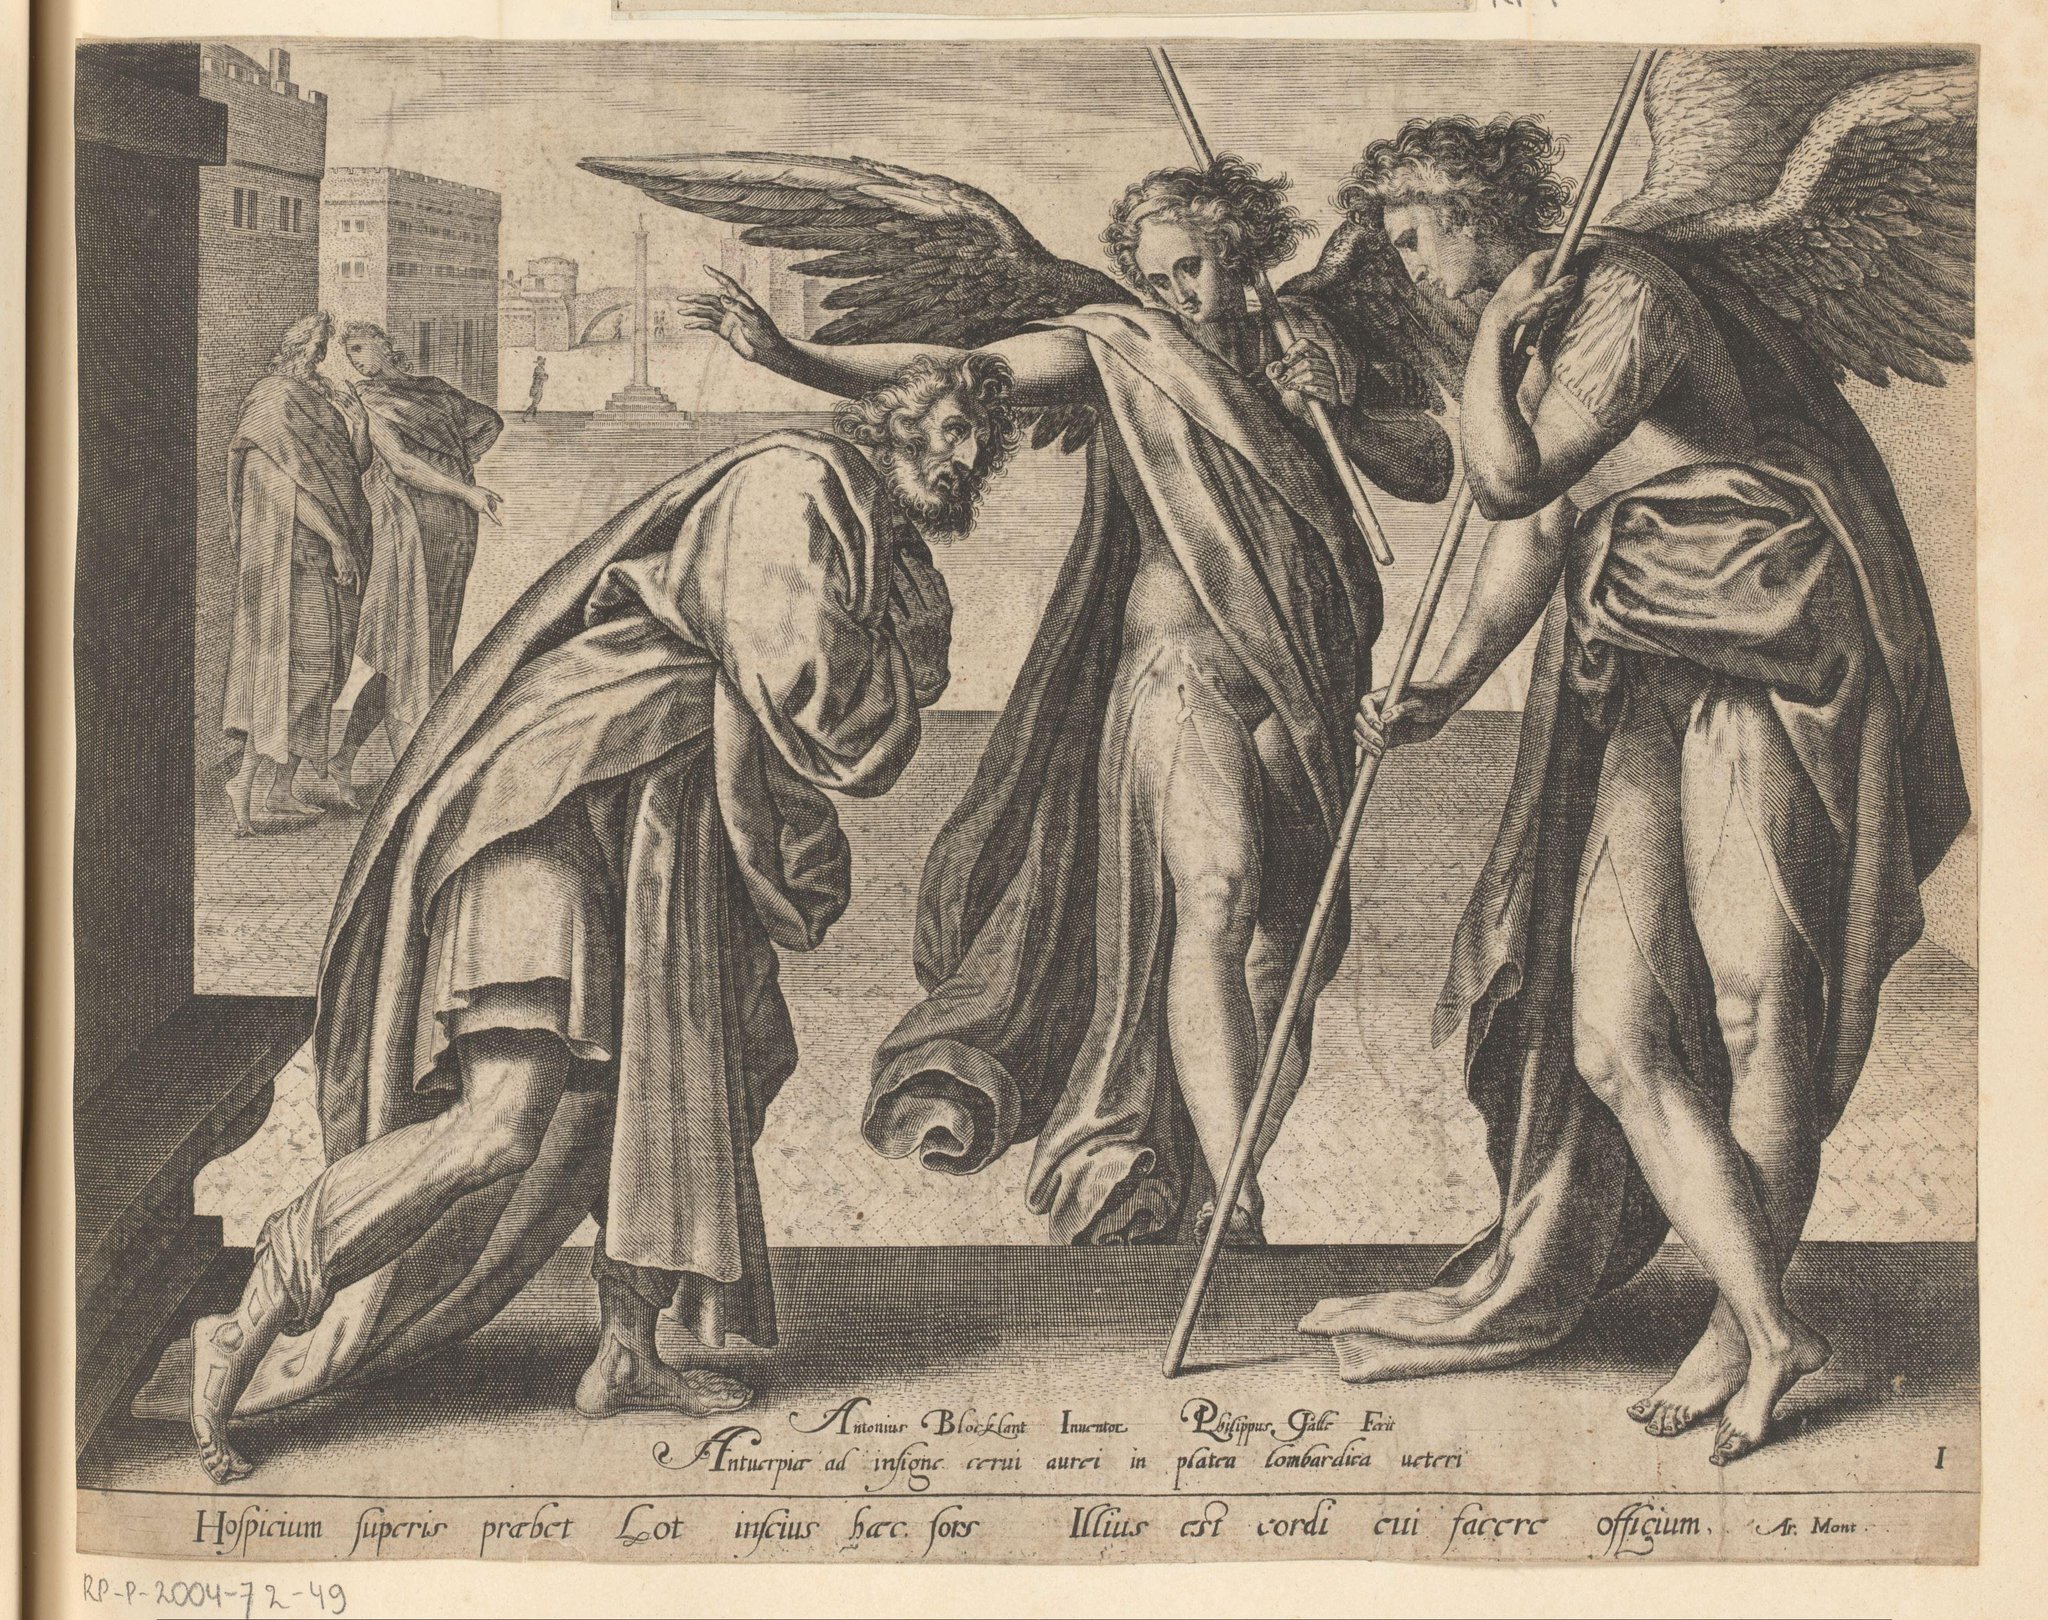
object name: album leaf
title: Lot en de twee engelen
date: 1547-1584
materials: paper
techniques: engraving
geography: antwerp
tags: lot and the two angels (genesis 19:1-23)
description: De samensteller heeft deze prent in het album geplakt als illustratie bij: Pilkington, Matthew en Johann Heinrich Füssli. A dictionary of painters, from the revival of the art to the present period. 4 dln. Londen: John Crowder, 1805, dl. 1, p. 52.